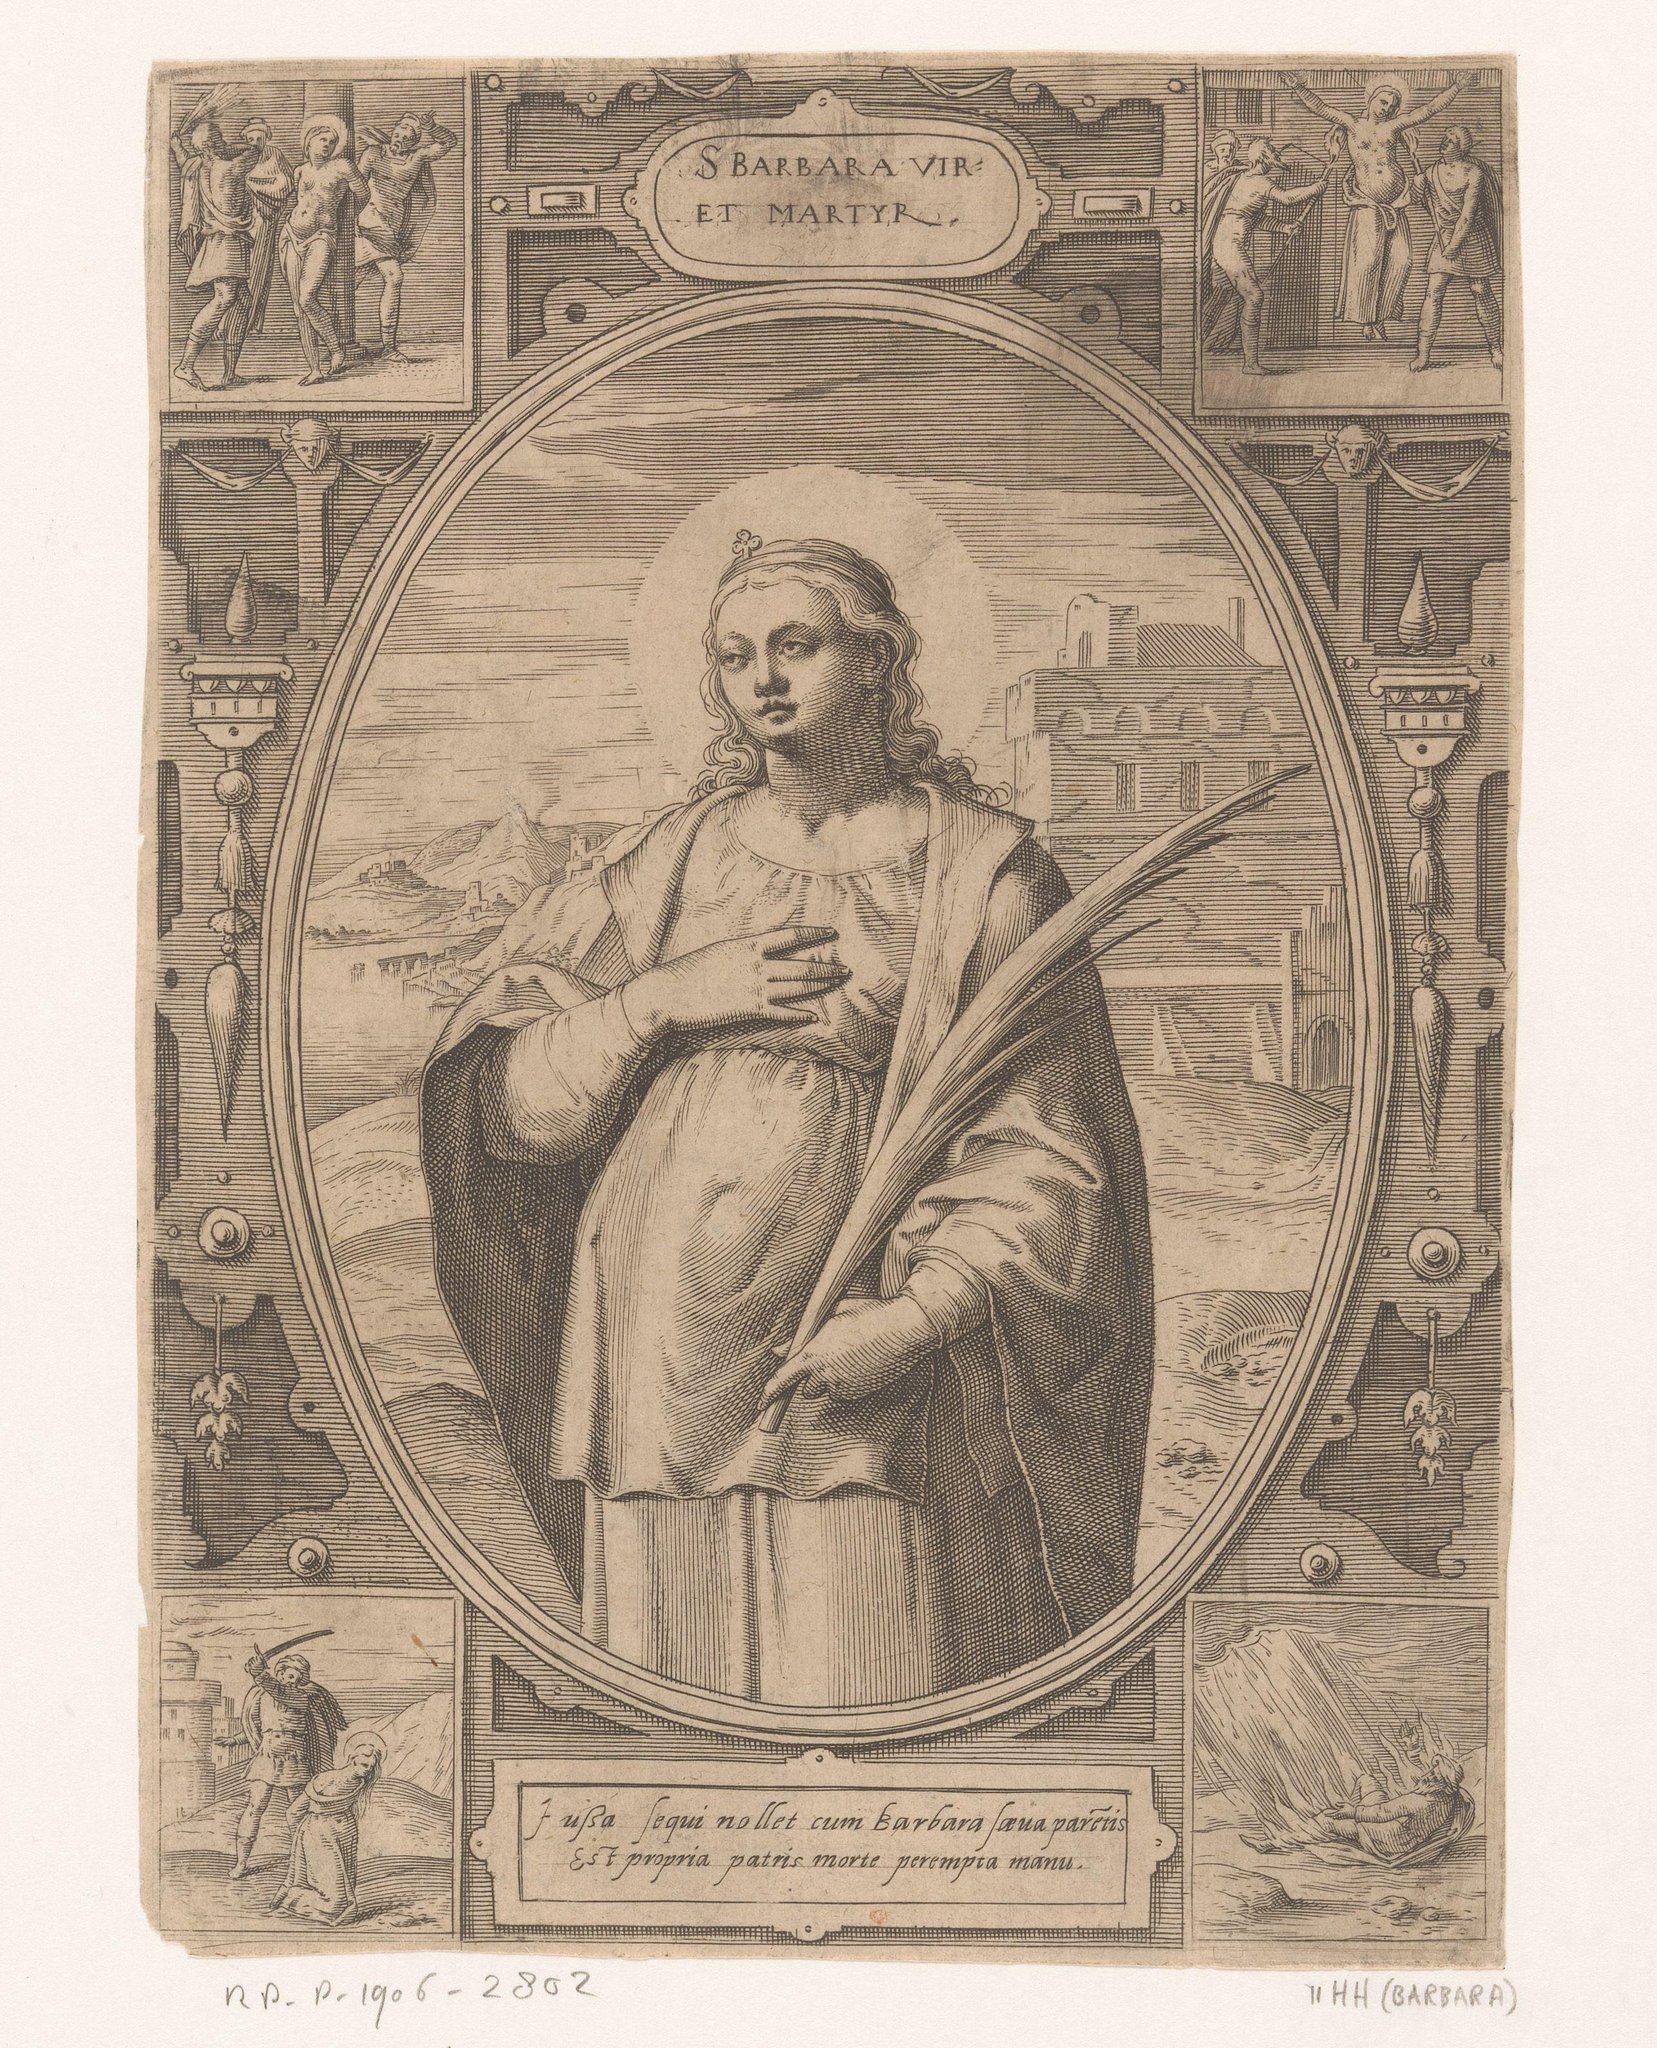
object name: print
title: H. Barbara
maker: Anonymous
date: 1600-1699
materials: paper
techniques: engraving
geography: netherlands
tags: the virgin martyr barbara; possible attributes: book, cannon(ball), crown, cross, chalice with wafer, dioscuros (her father), peacock feather, sword, torches, mason's tools, tower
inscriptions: collector's mark: Lugt 2228